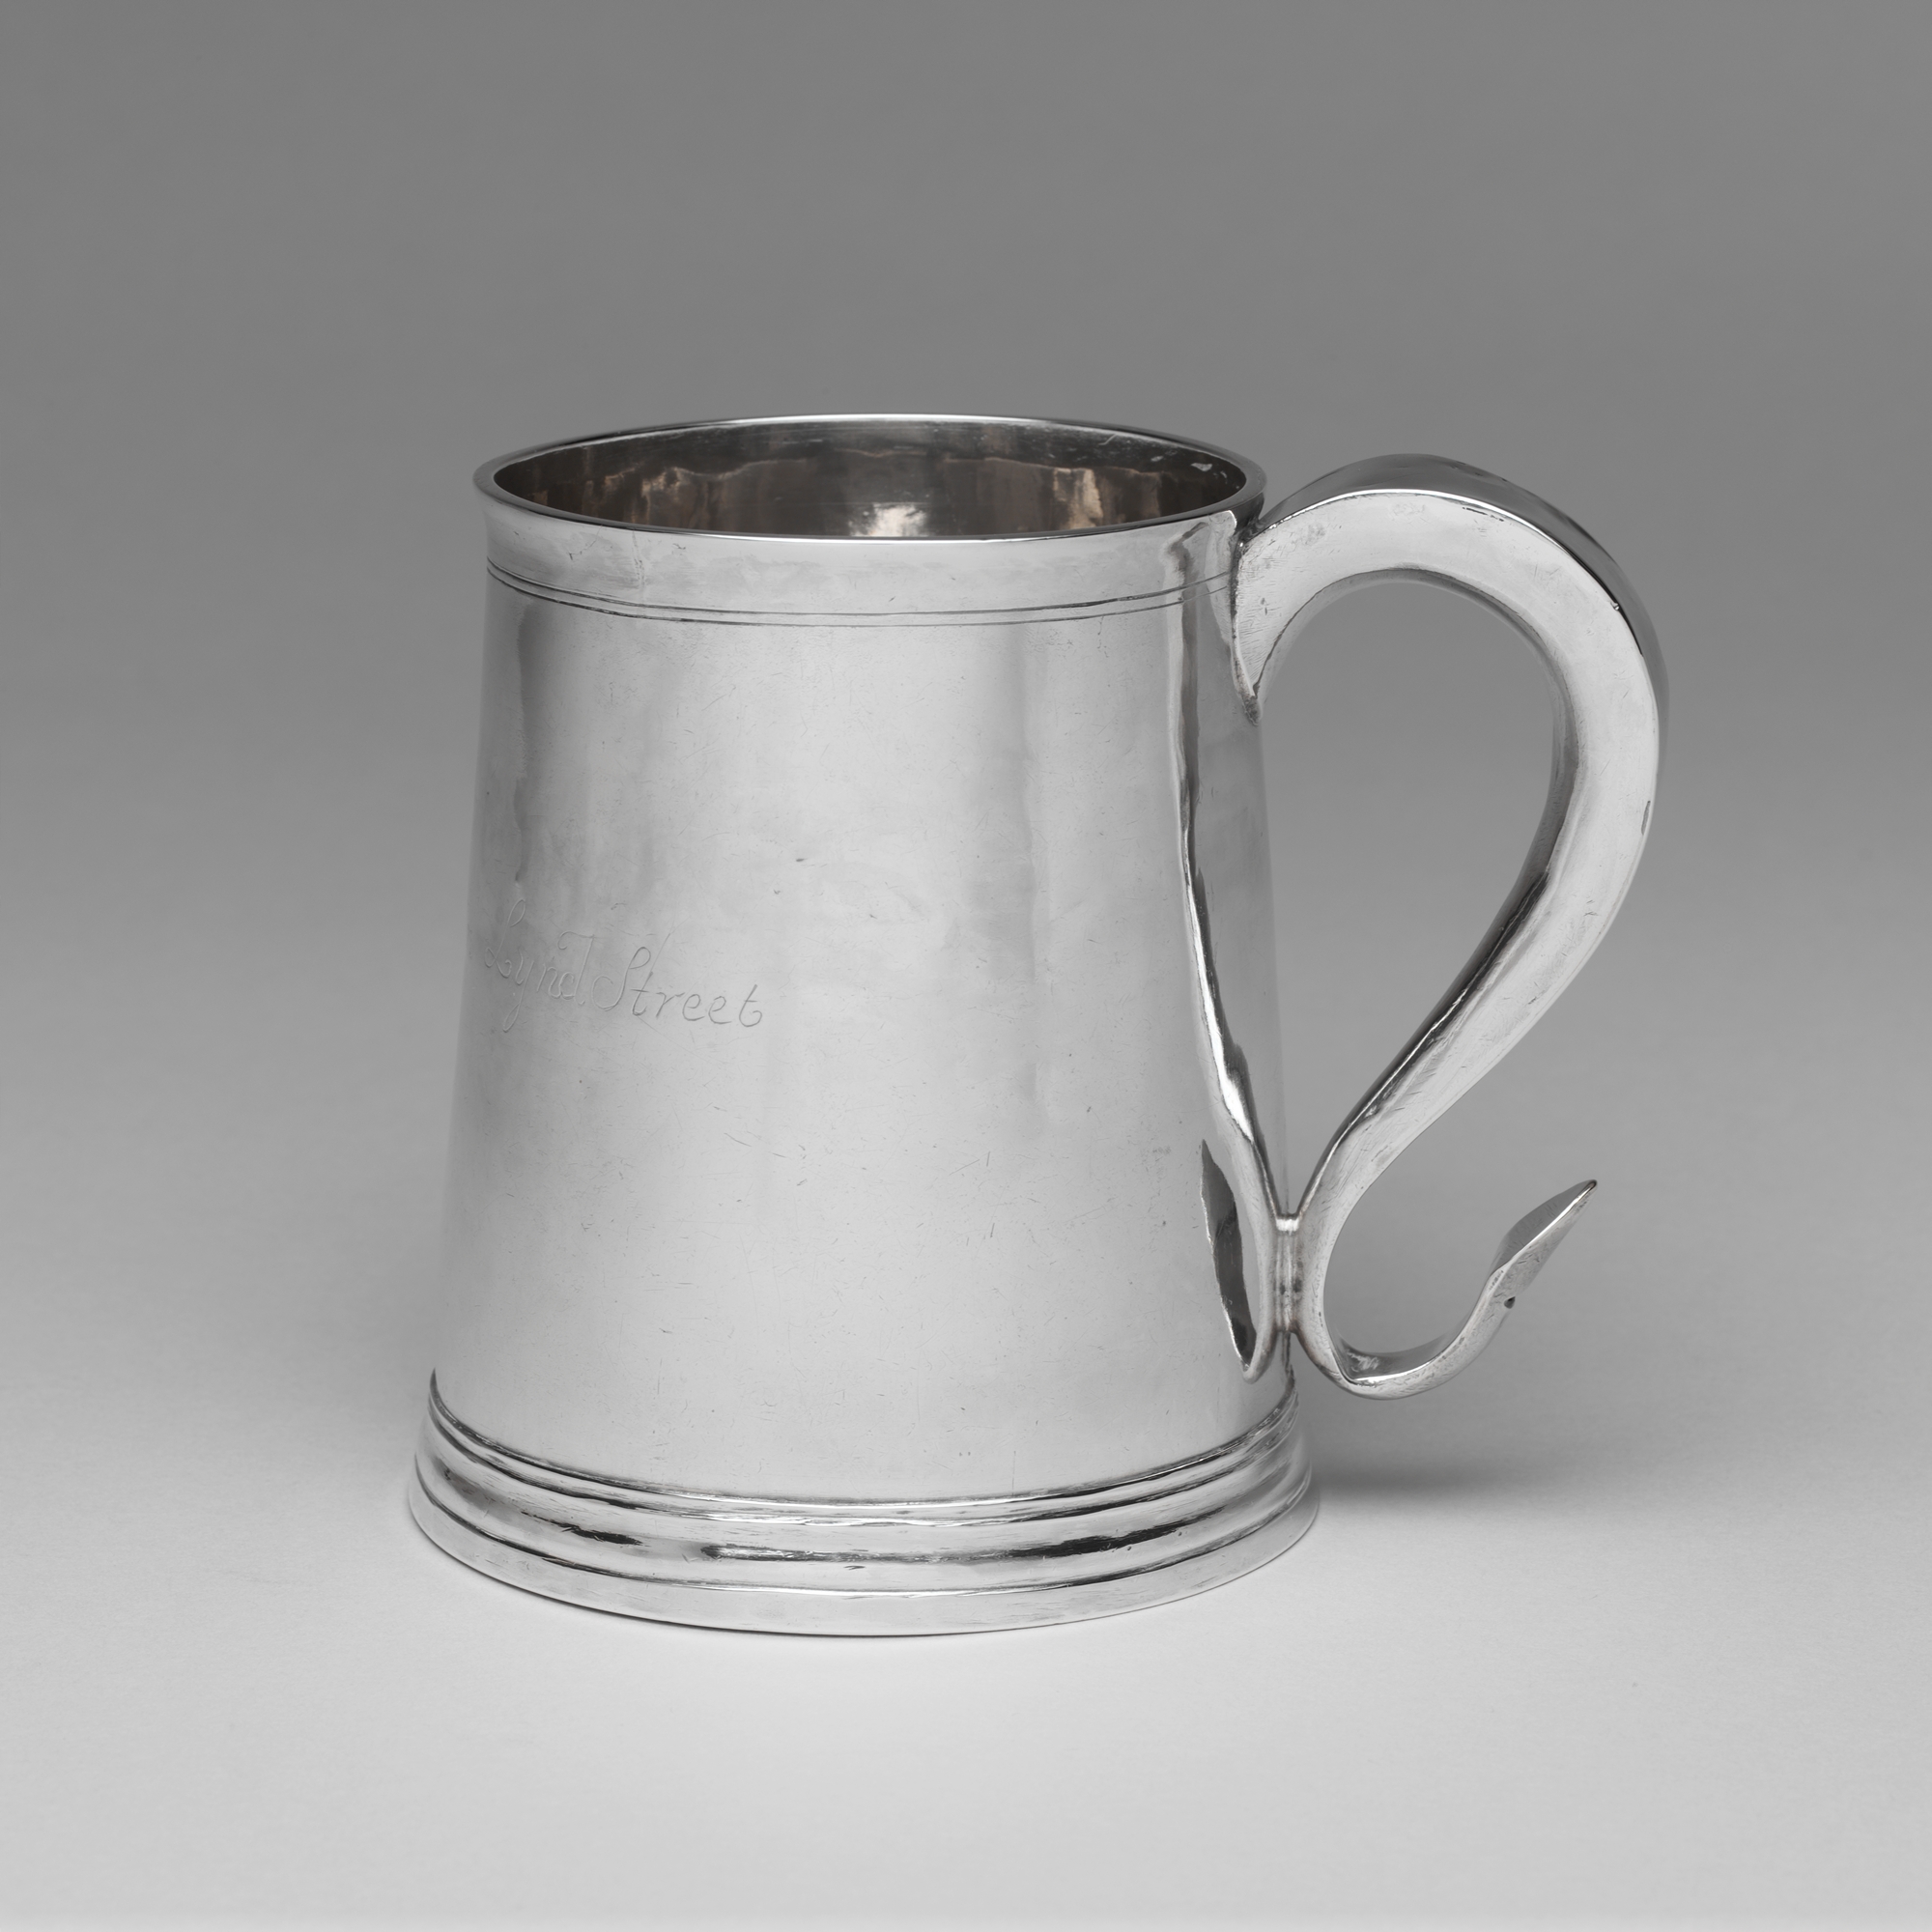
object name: mug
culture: american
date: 1740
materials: silver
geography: united states